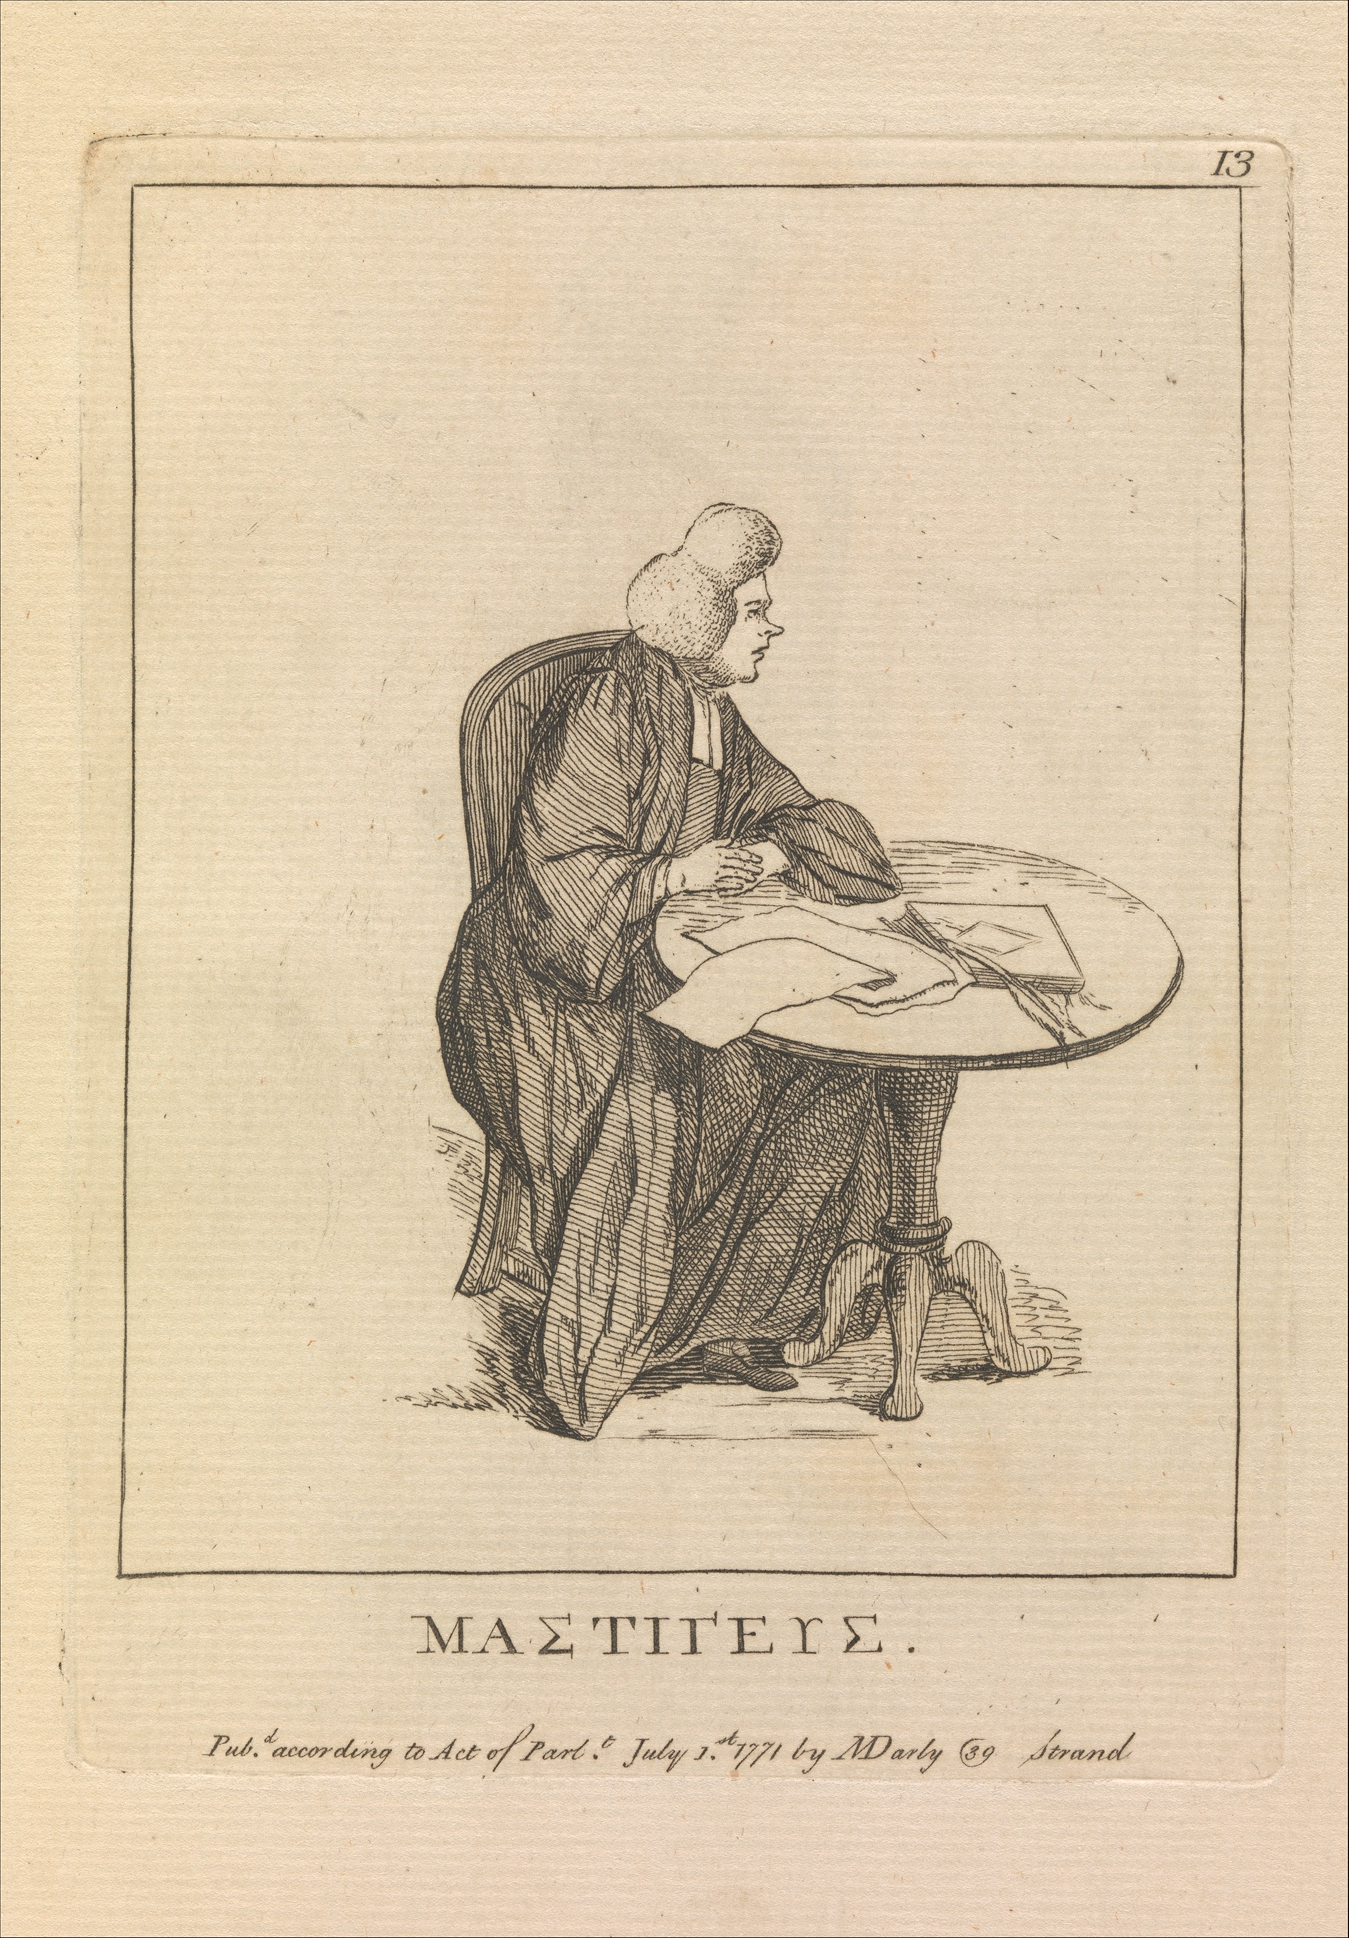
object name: print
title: Mastigeus [in Greek letters]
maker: henry william bunbury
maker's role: artist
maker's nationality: british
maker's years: 1750-1811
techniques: etching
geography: london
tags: men